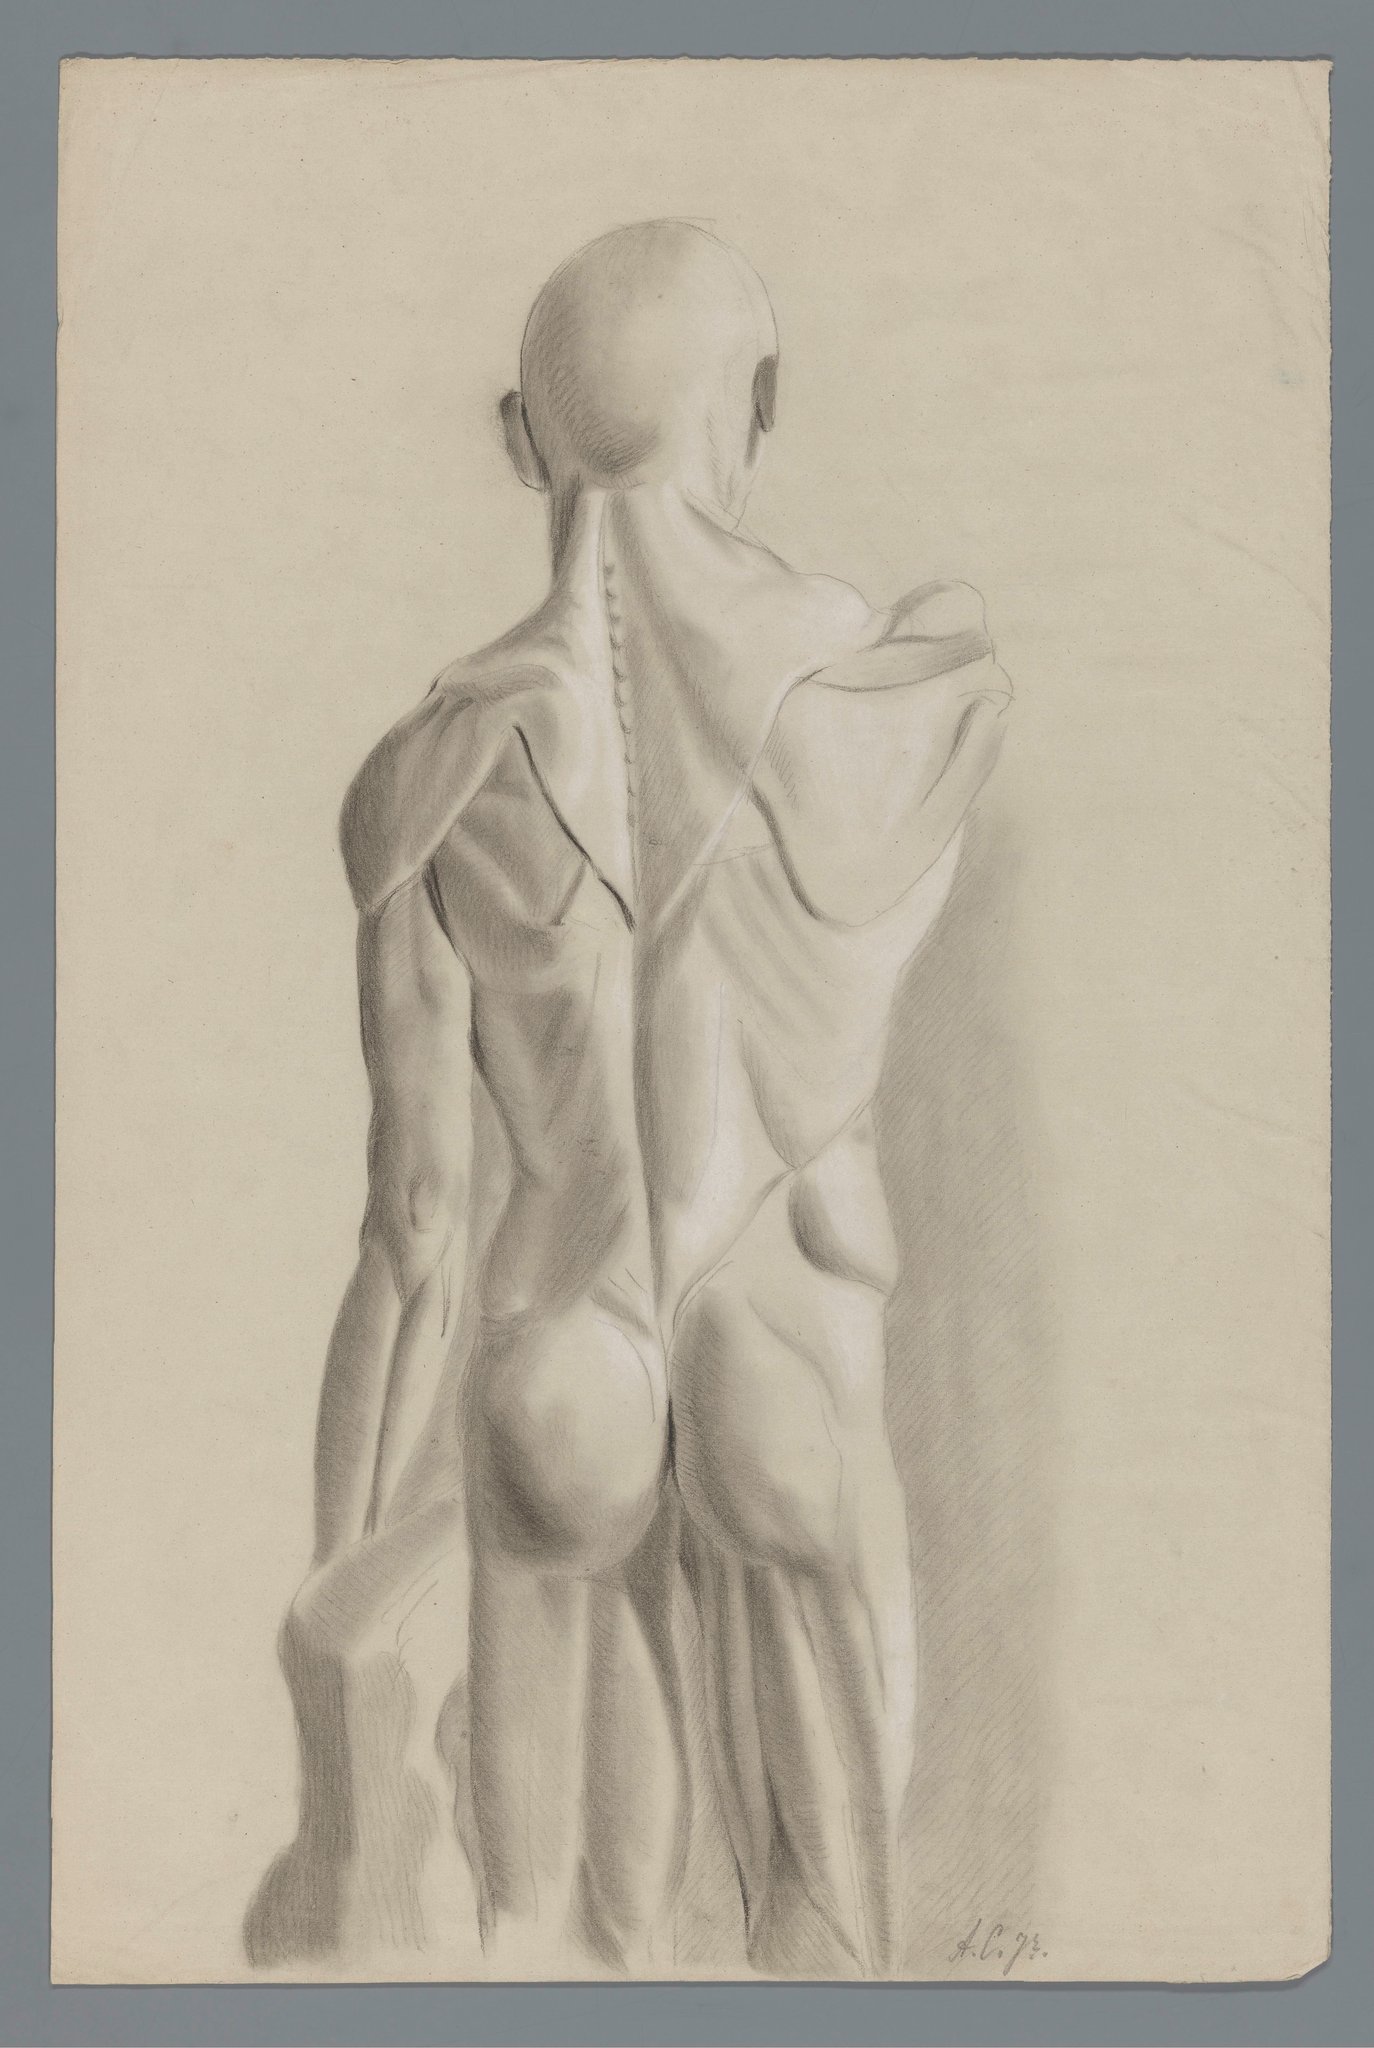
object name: drawing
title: Anatomisch gipsmodel, op de rug gezien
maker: alexander cranendoncq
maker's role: draughtsman, print maker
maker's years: 1799-1869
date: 1800-1900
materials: chalk, paper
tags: piece of sculpture, reproduction of a piece of sculpture (+ reproduction ~ work of art), muscles